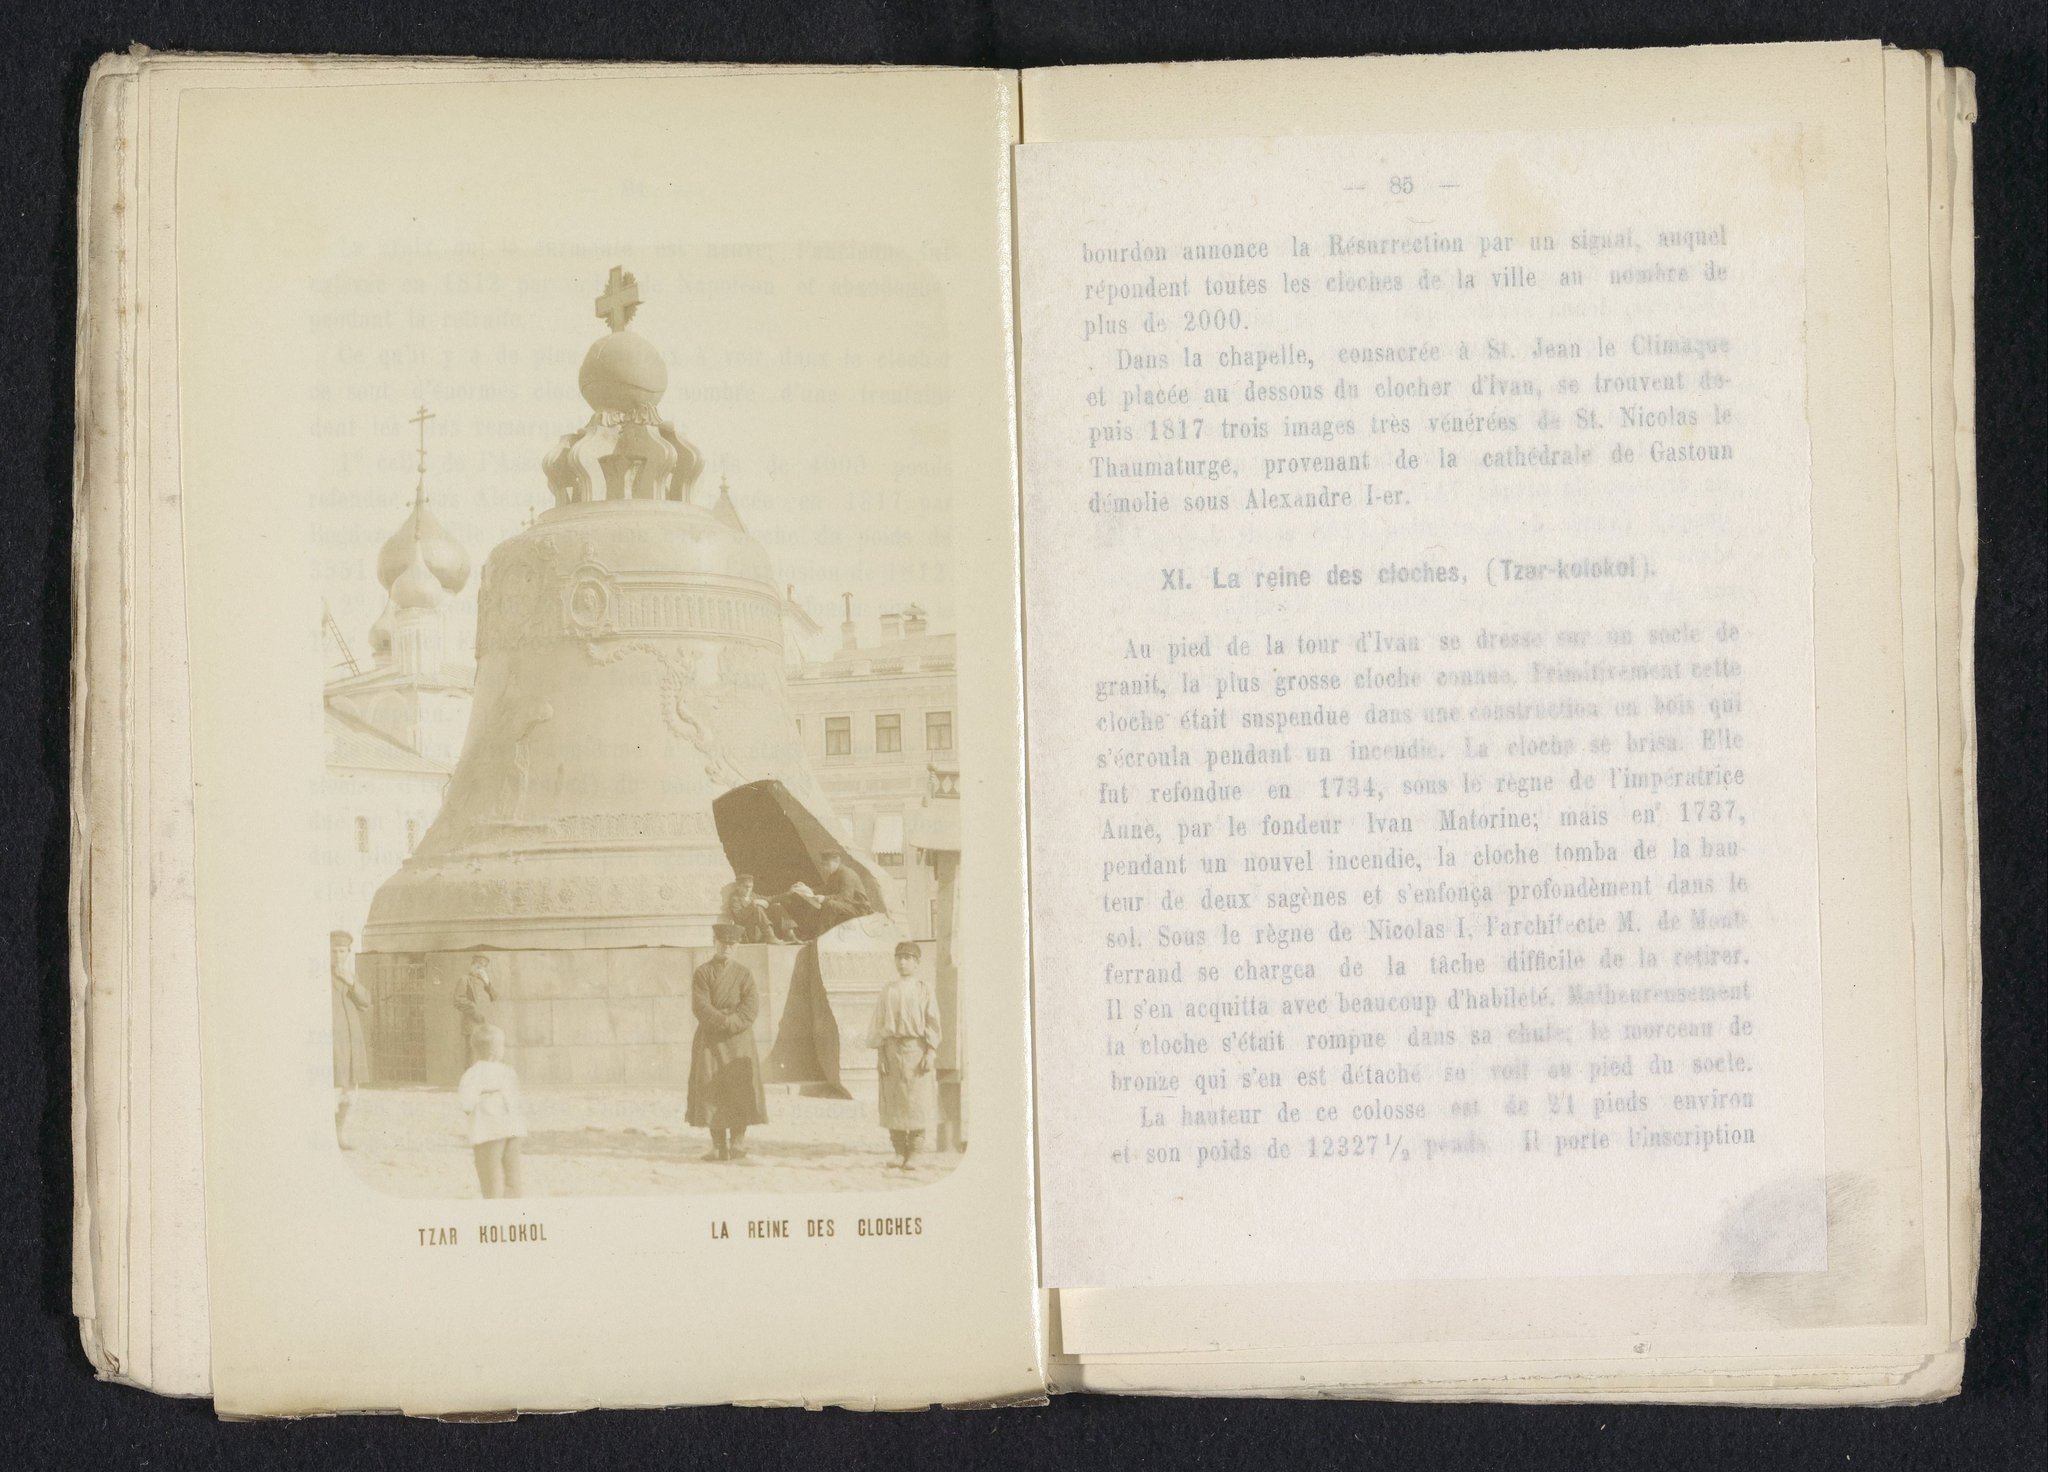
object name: page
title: La reine des cloches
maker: Anonymous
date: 1876-1881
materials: photographic support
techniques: albumen print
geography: moscow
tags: church bell